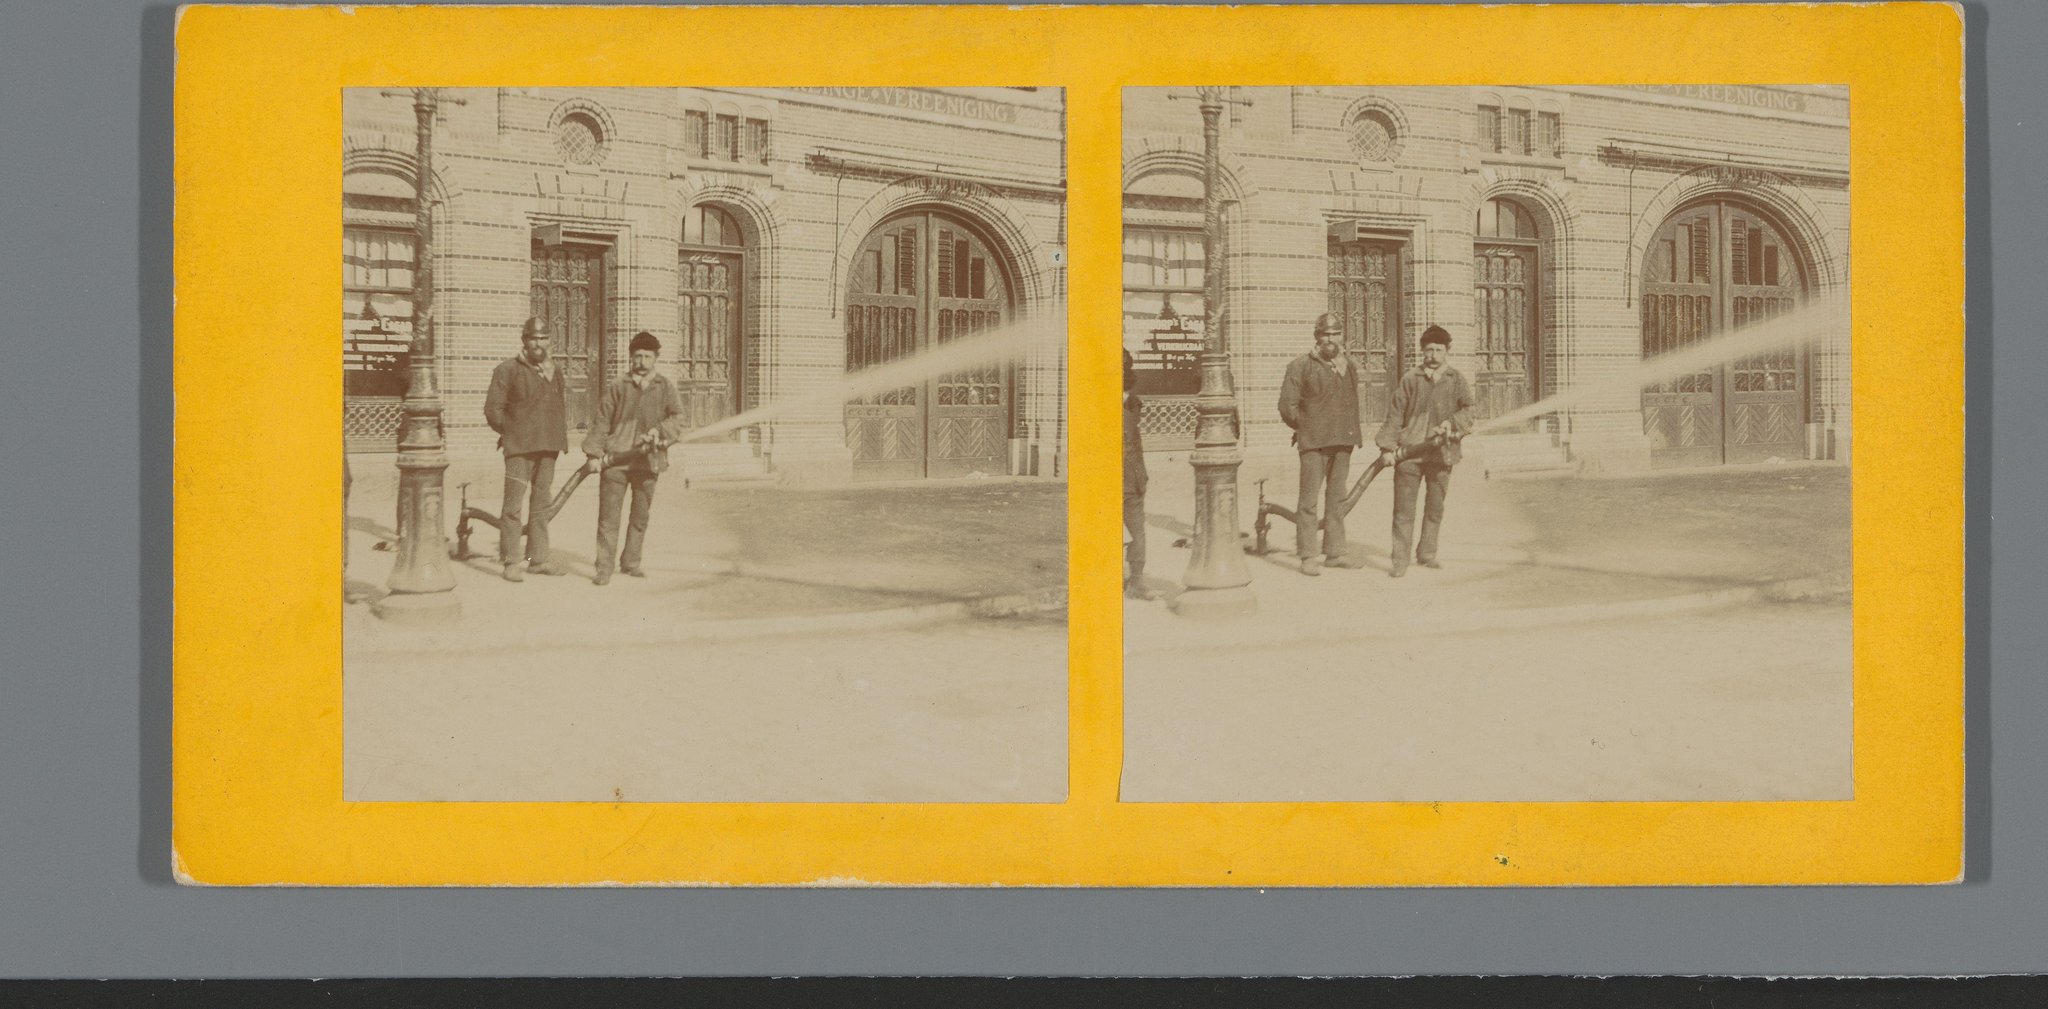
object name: stereograph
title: Twee brandweermannen op de Weteringschans in Amsterdam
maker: Anonymous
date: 1861-1870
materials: cardboard, paper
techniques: albumen print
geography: amsterdam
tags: firemen